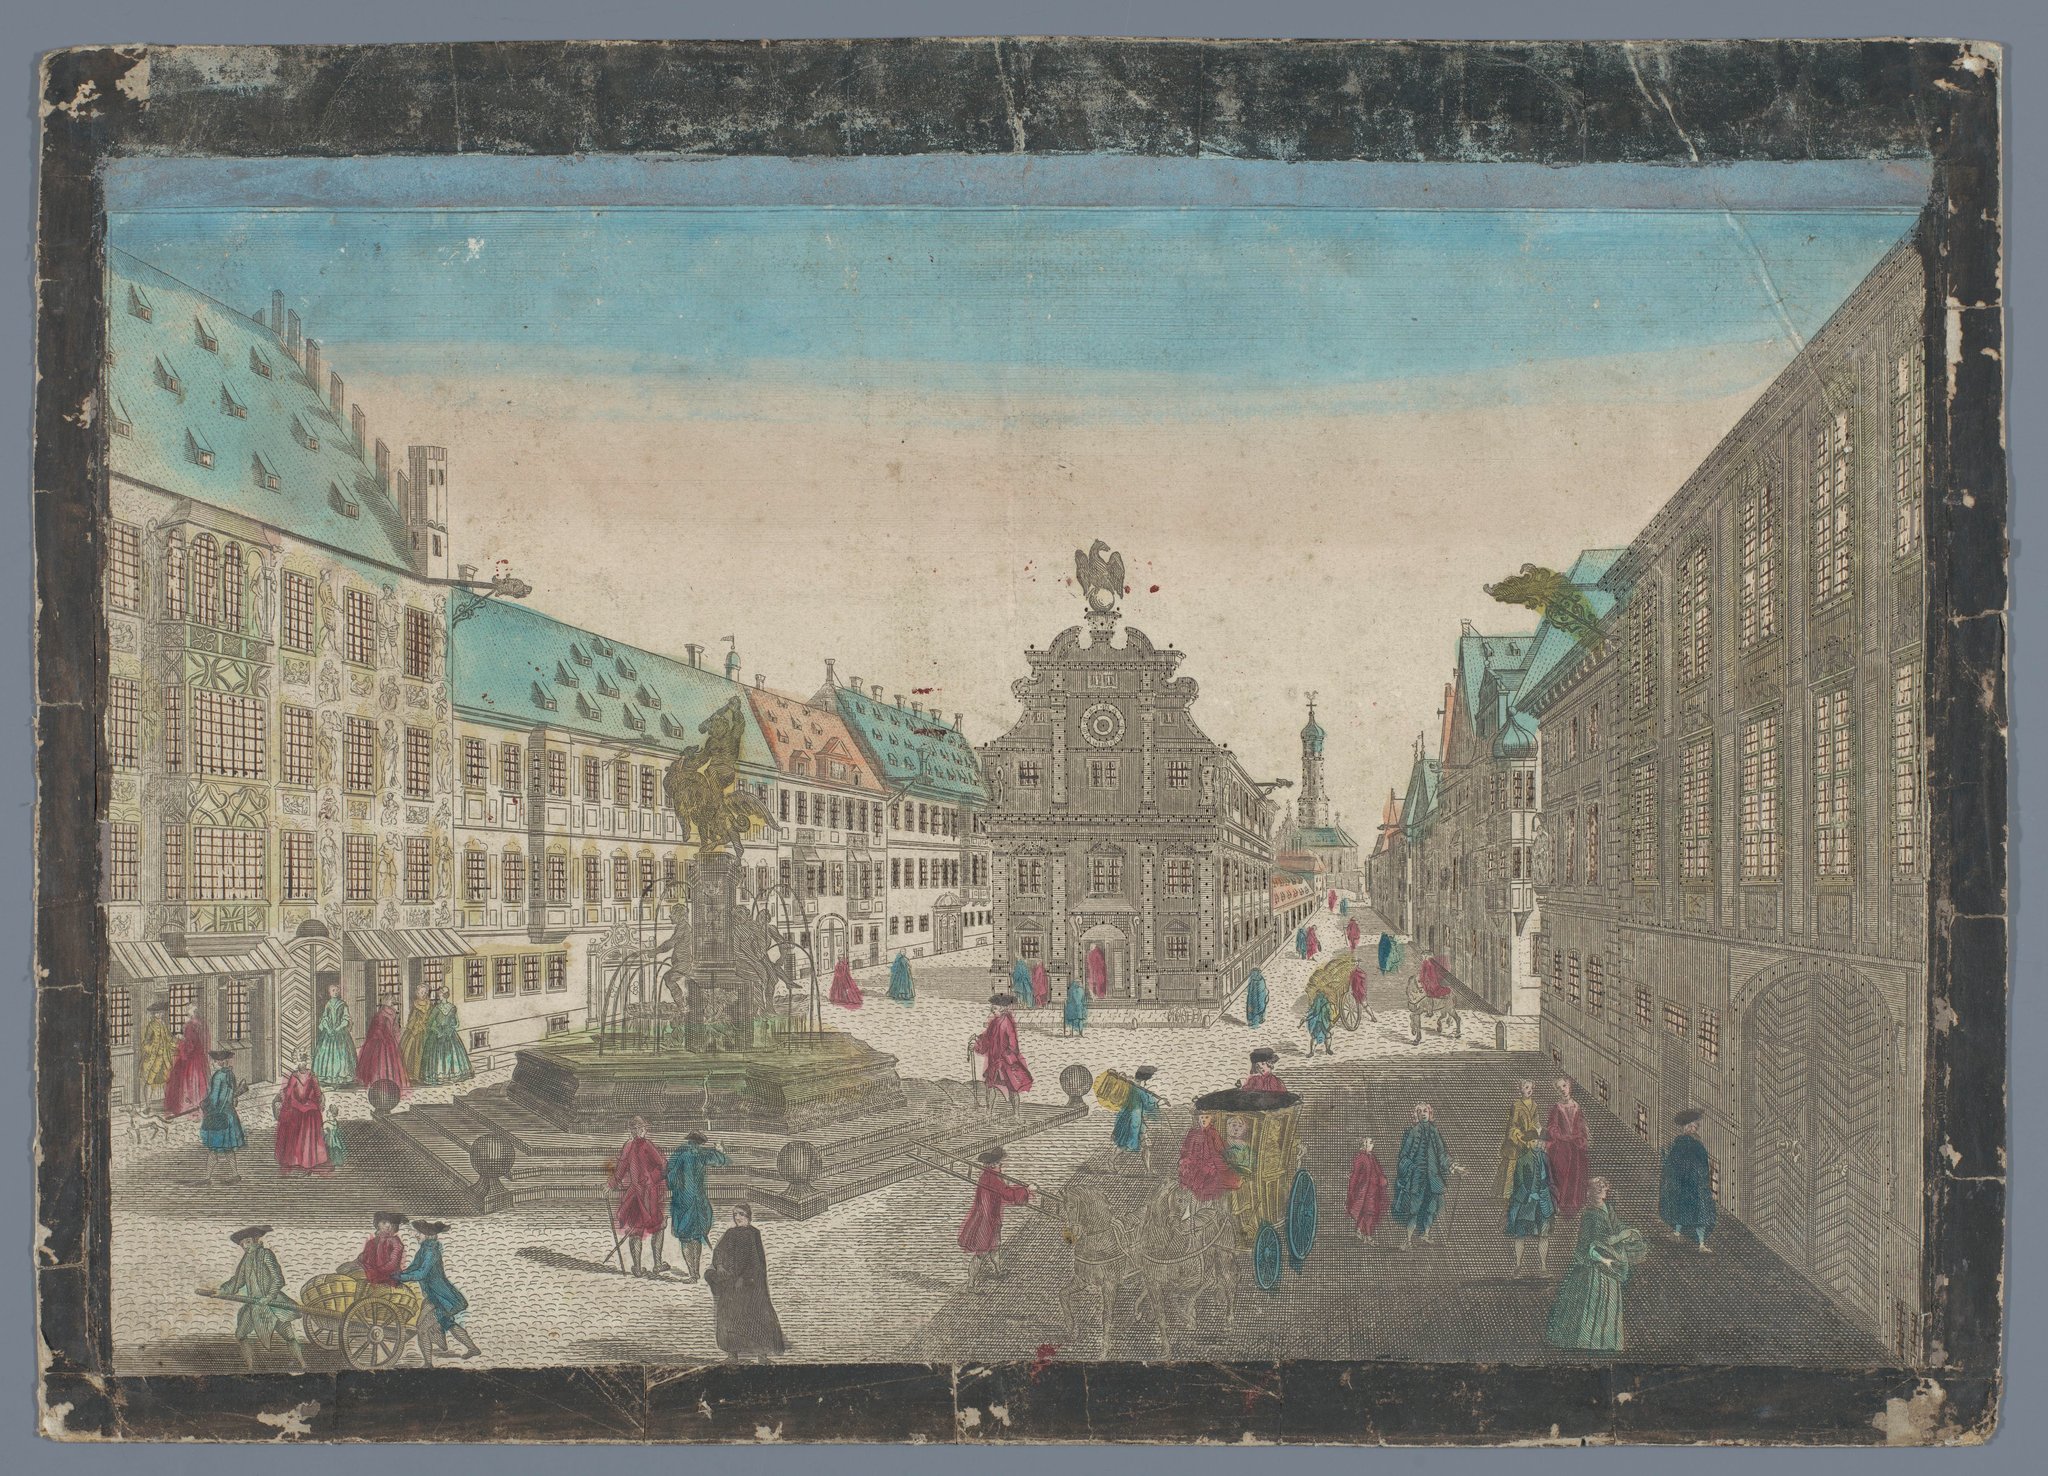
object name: print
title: Gezicht op de wijnmarkt te Augsburg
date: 1742-1801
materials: cardboard, paint, paper, watercolor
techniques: brush, cutting, etching, perforating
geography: augsburg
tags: storing, conserving, preserving (of products), abbey, monastery, convent ~ roman catholic church, market, square, place, circus, etc. (+ city(-scape) with figures, staffage), ornamental fountain (+ city(-scape) with figures, staffage)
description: Mogelijk rechtsboven genummerd geweest: 11. Mogelijk linksonder genummerd geweest: 13. De serie “Augsburg”, met het nummer 13, bevat vier prenten met de nummers 9-12, waarvan dit mogelijk nummer 11 is.